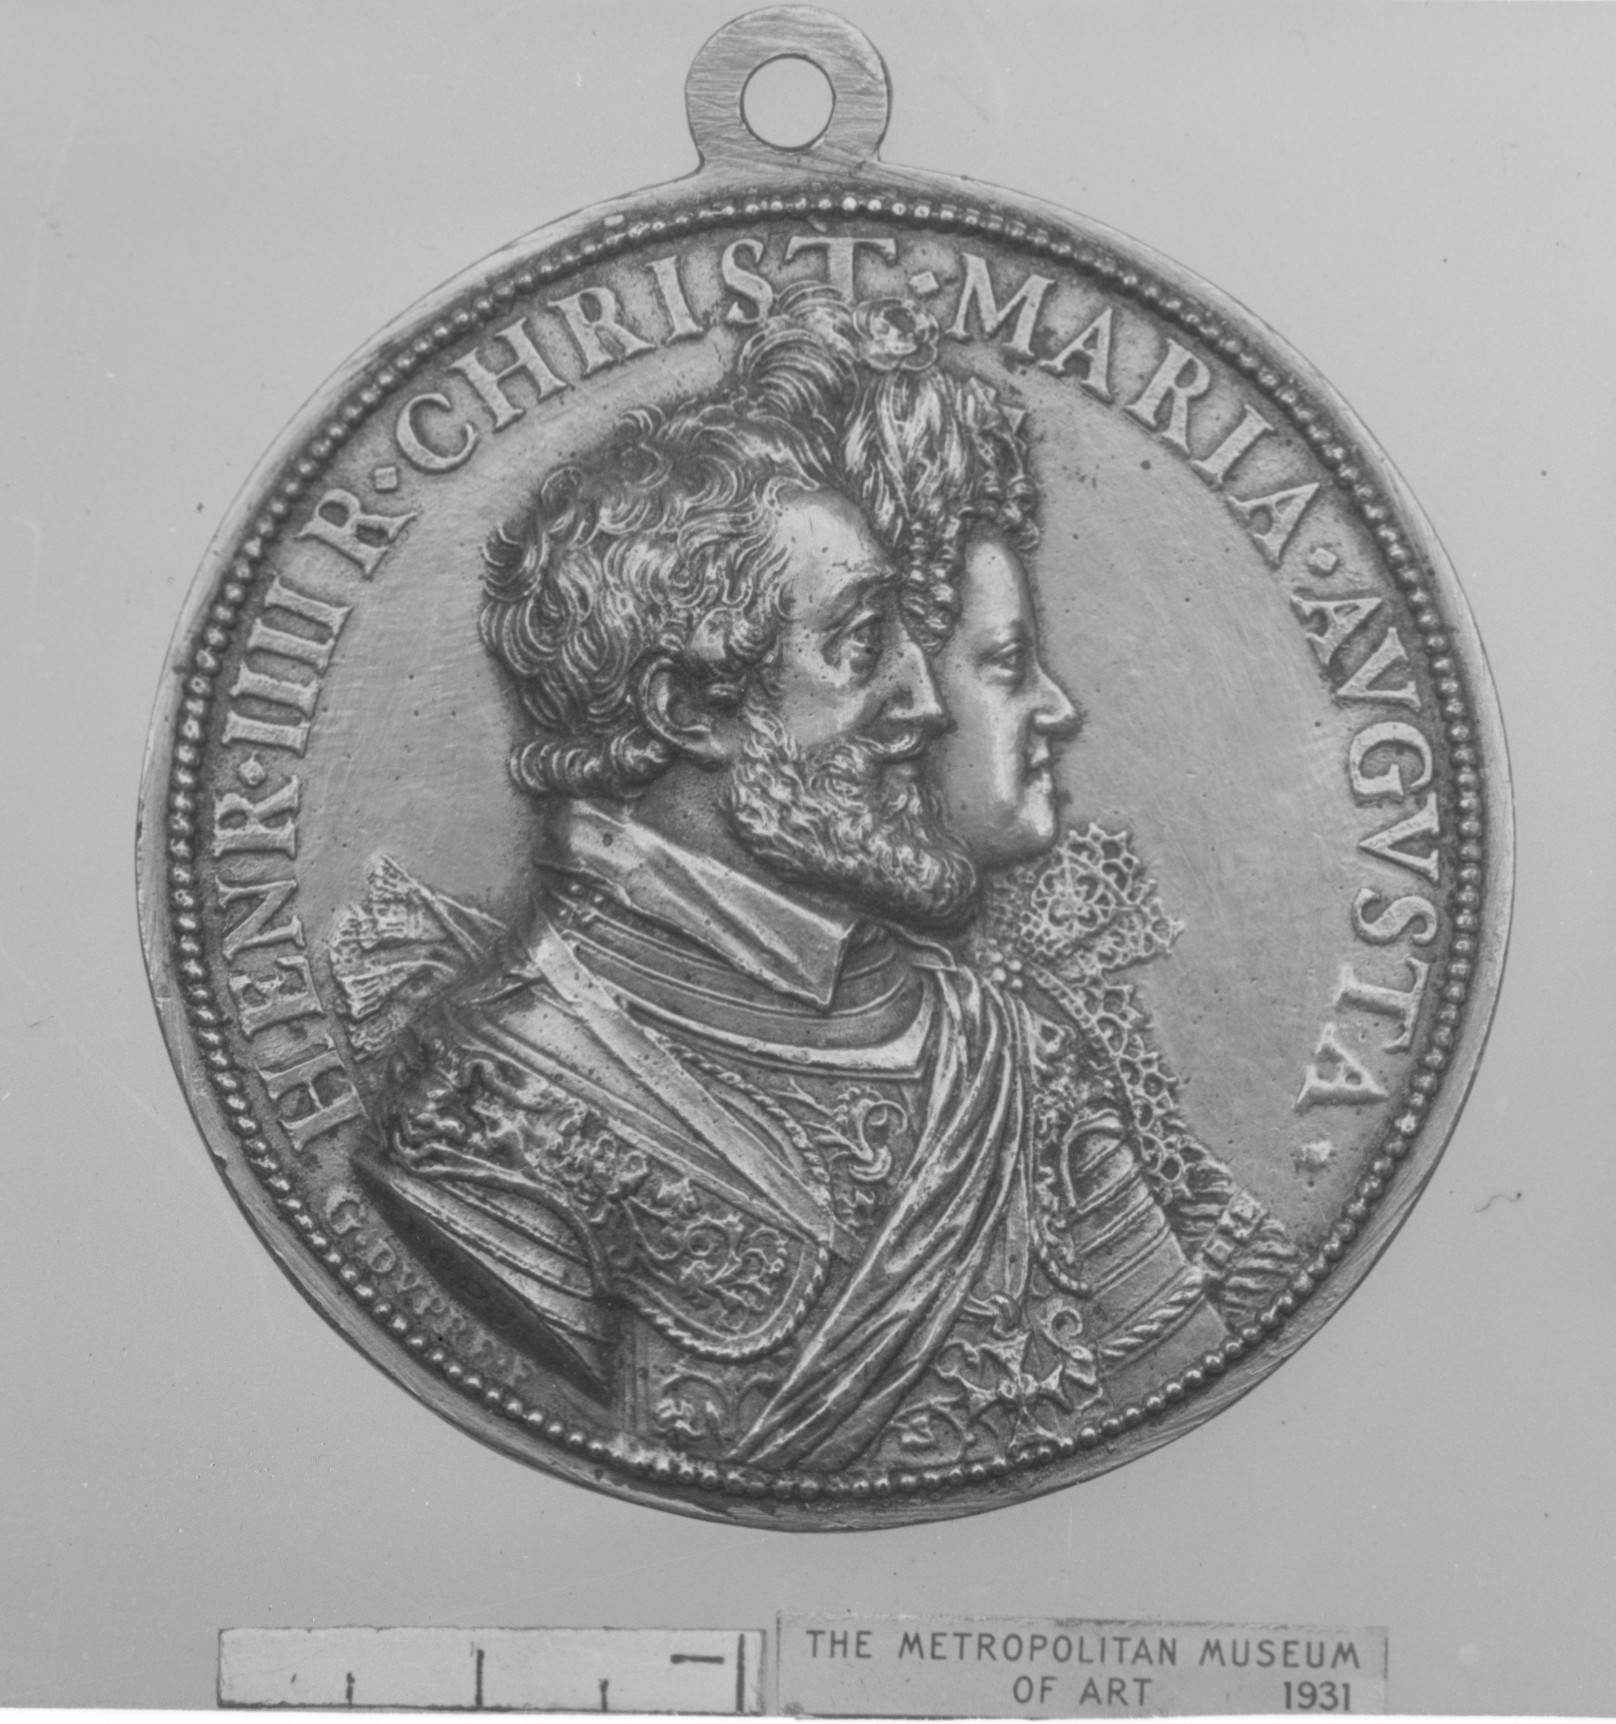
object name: medal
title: Henry IV, King of France (b. 1553, r. 1589–1610) and Marie de Médicis, his consort (1573–1642)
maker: guillaume dupré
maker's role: artist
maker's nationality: french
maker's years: 1579-1640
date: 1603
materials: gilt bronze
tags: kings,profiles